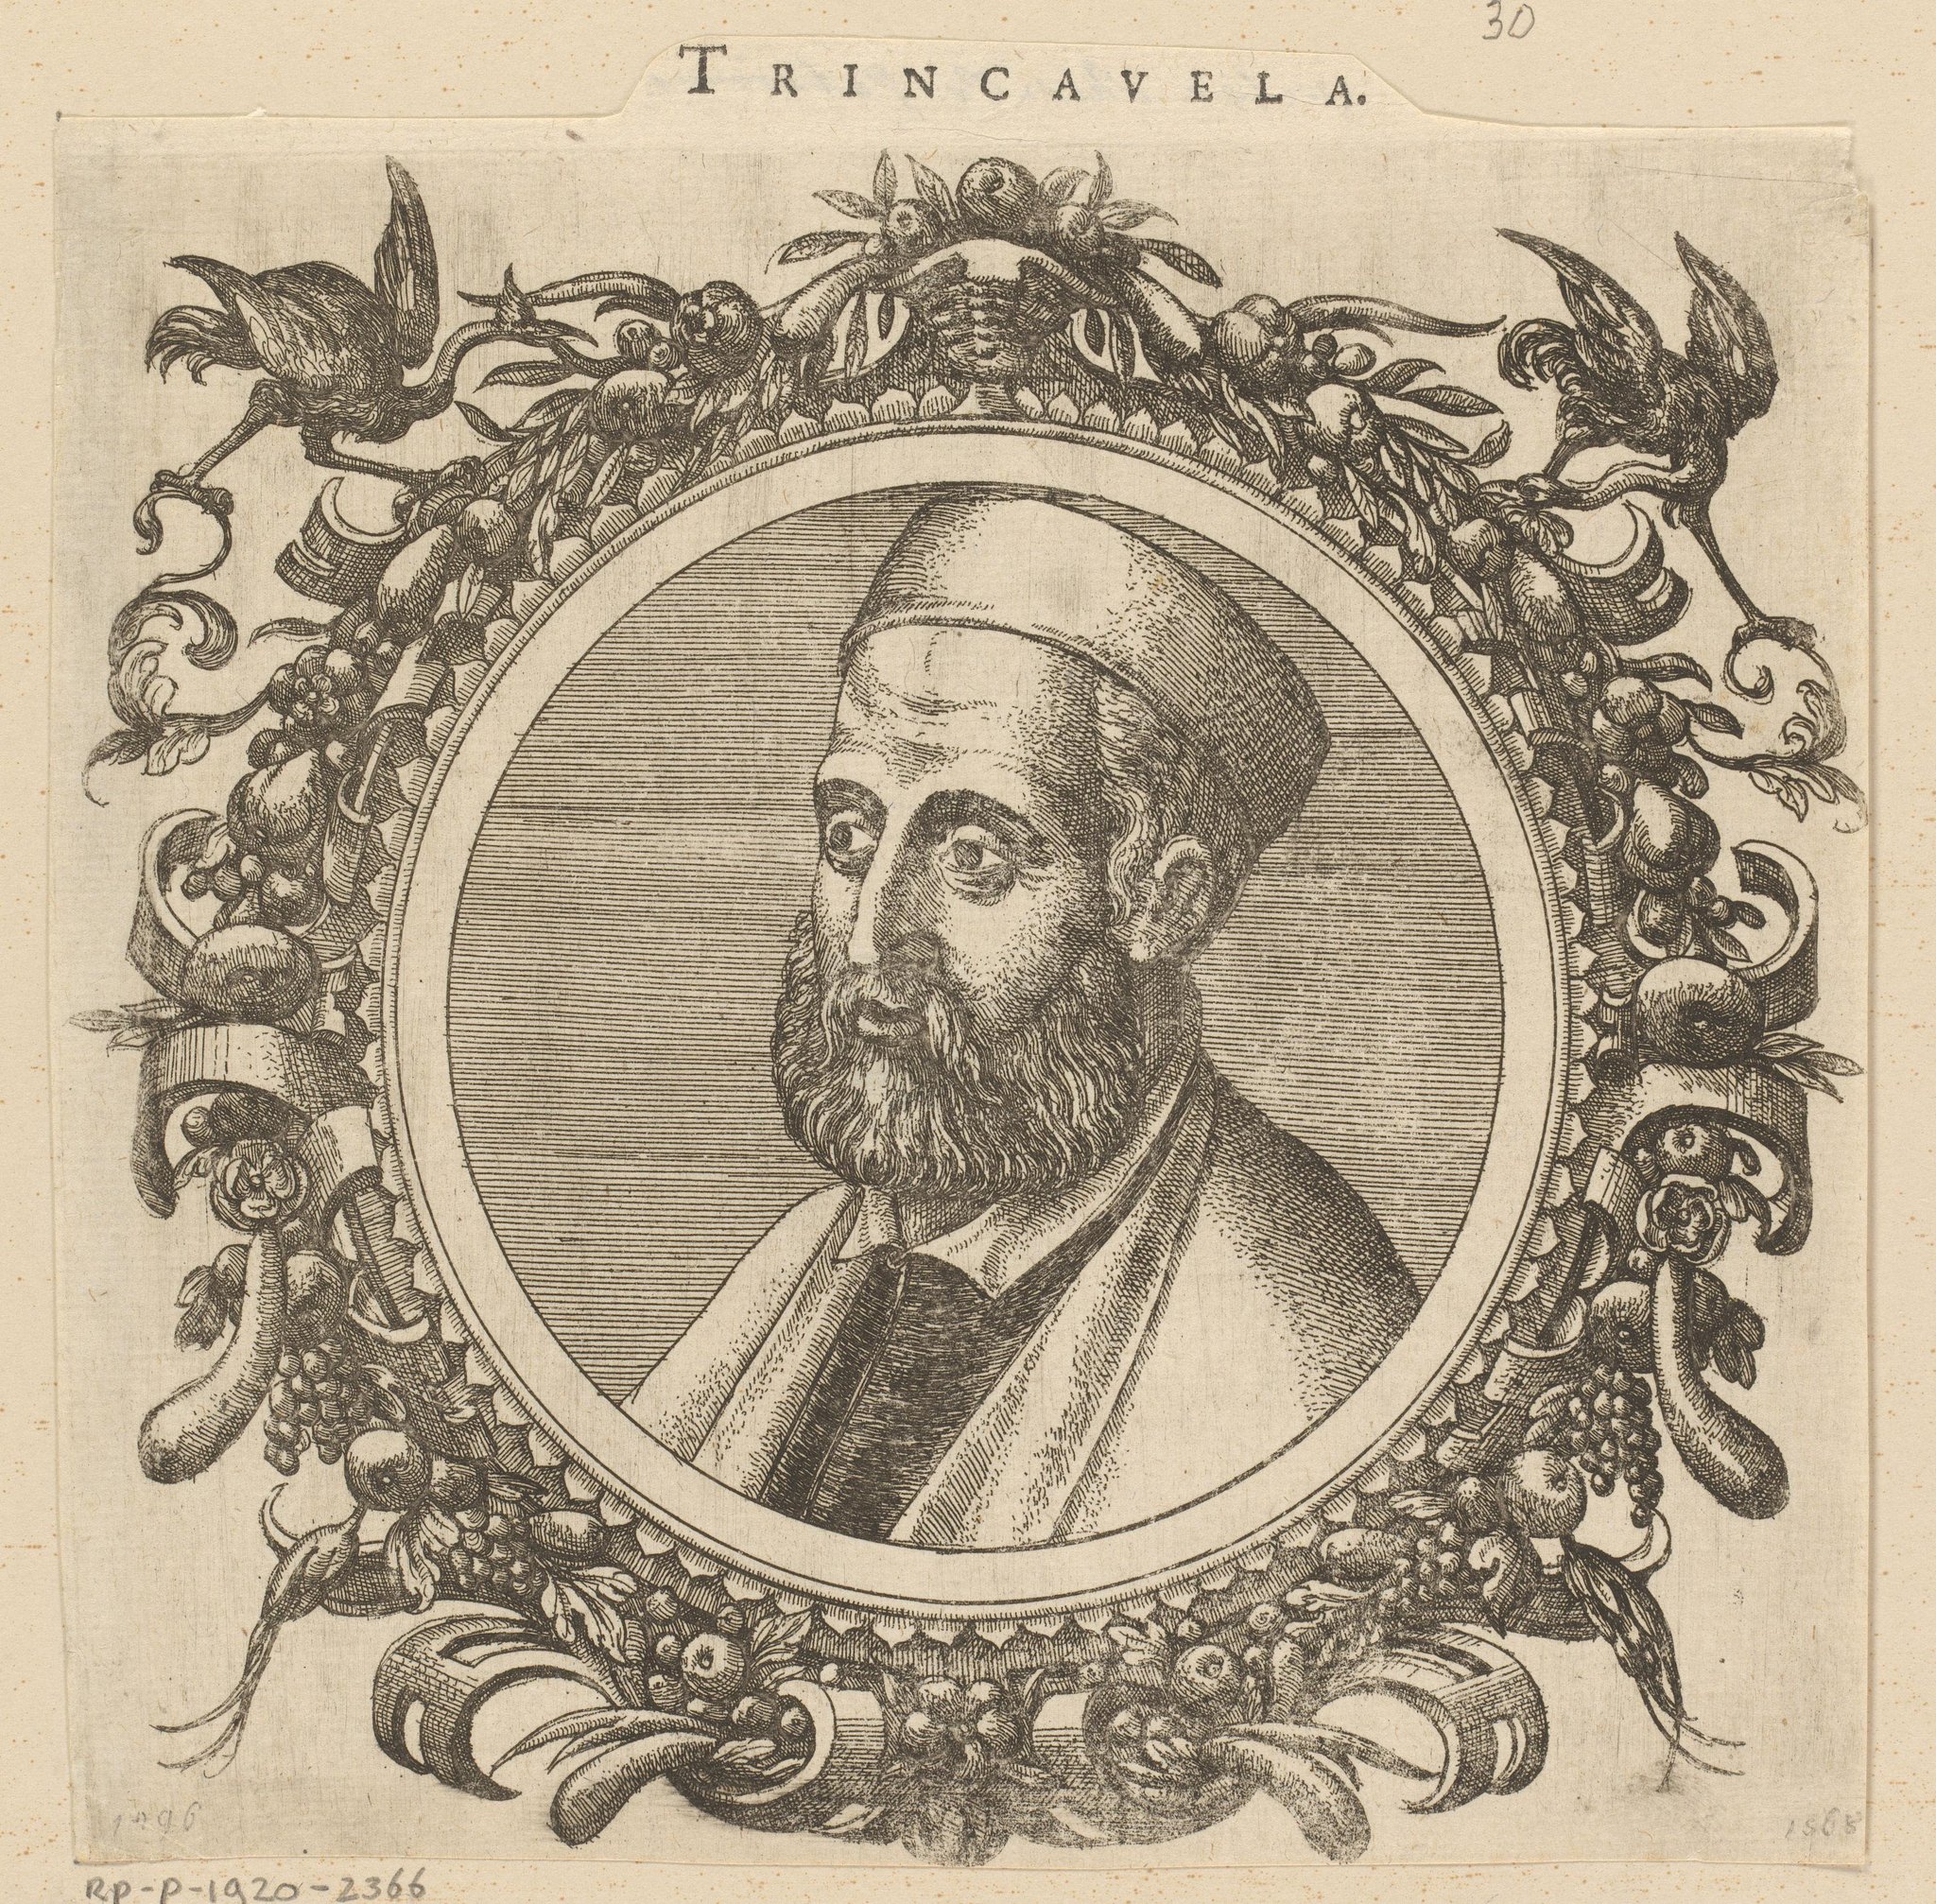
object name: print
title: Icones veterum aliquot, ac recentium medicorum (...)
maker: pieter van der borcht (i)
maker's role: print maker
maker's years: 1545-1608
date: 1574-1612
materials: paper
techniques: etching, letterpress printing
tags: fruits and vegetables ~ ornament, scholar, philosopher, historical persons, physician, doctor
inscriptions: collector's mark: Lugt 2228, inscription: ‘Victor. [...]edi. Pr. patavinus’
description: Portretbuste in ronde ornamentale omlijsting.